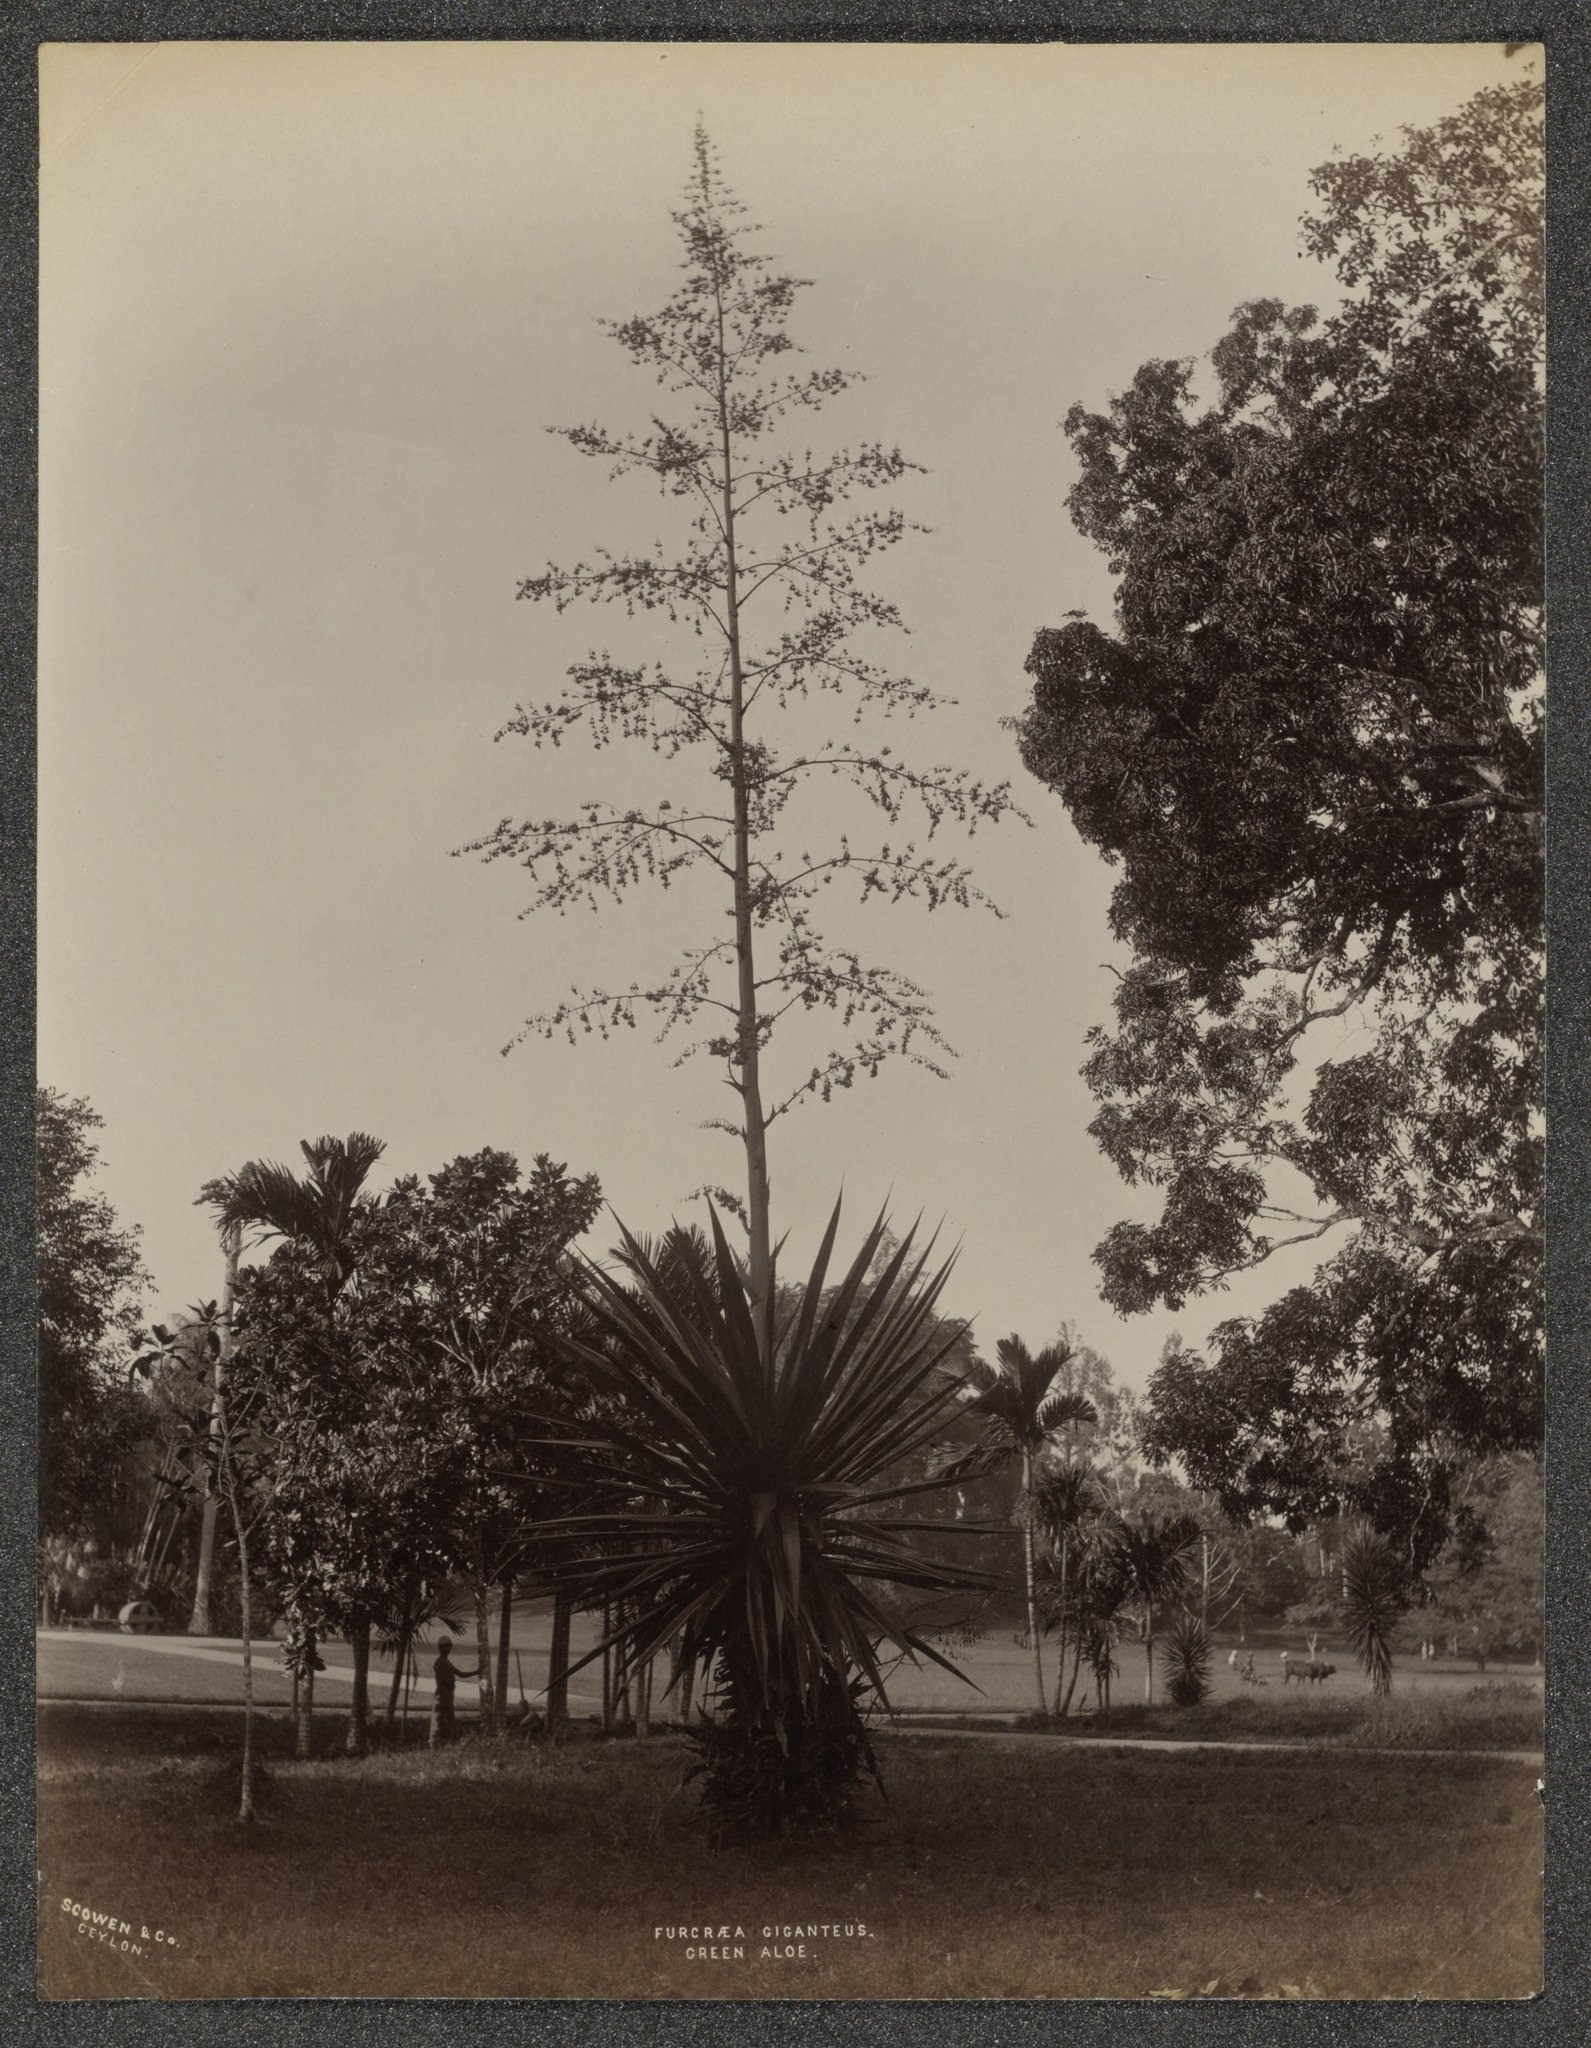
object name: photograph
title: Furcraea Giganteus. Green Aloe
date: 1875-1880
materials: paper, photographic support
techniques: albumen print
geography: sri lanka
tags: plants; vegetation, sri lanka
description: Onderdeel van Album met 50 foto's van een reis door Zuidoost-Azië.